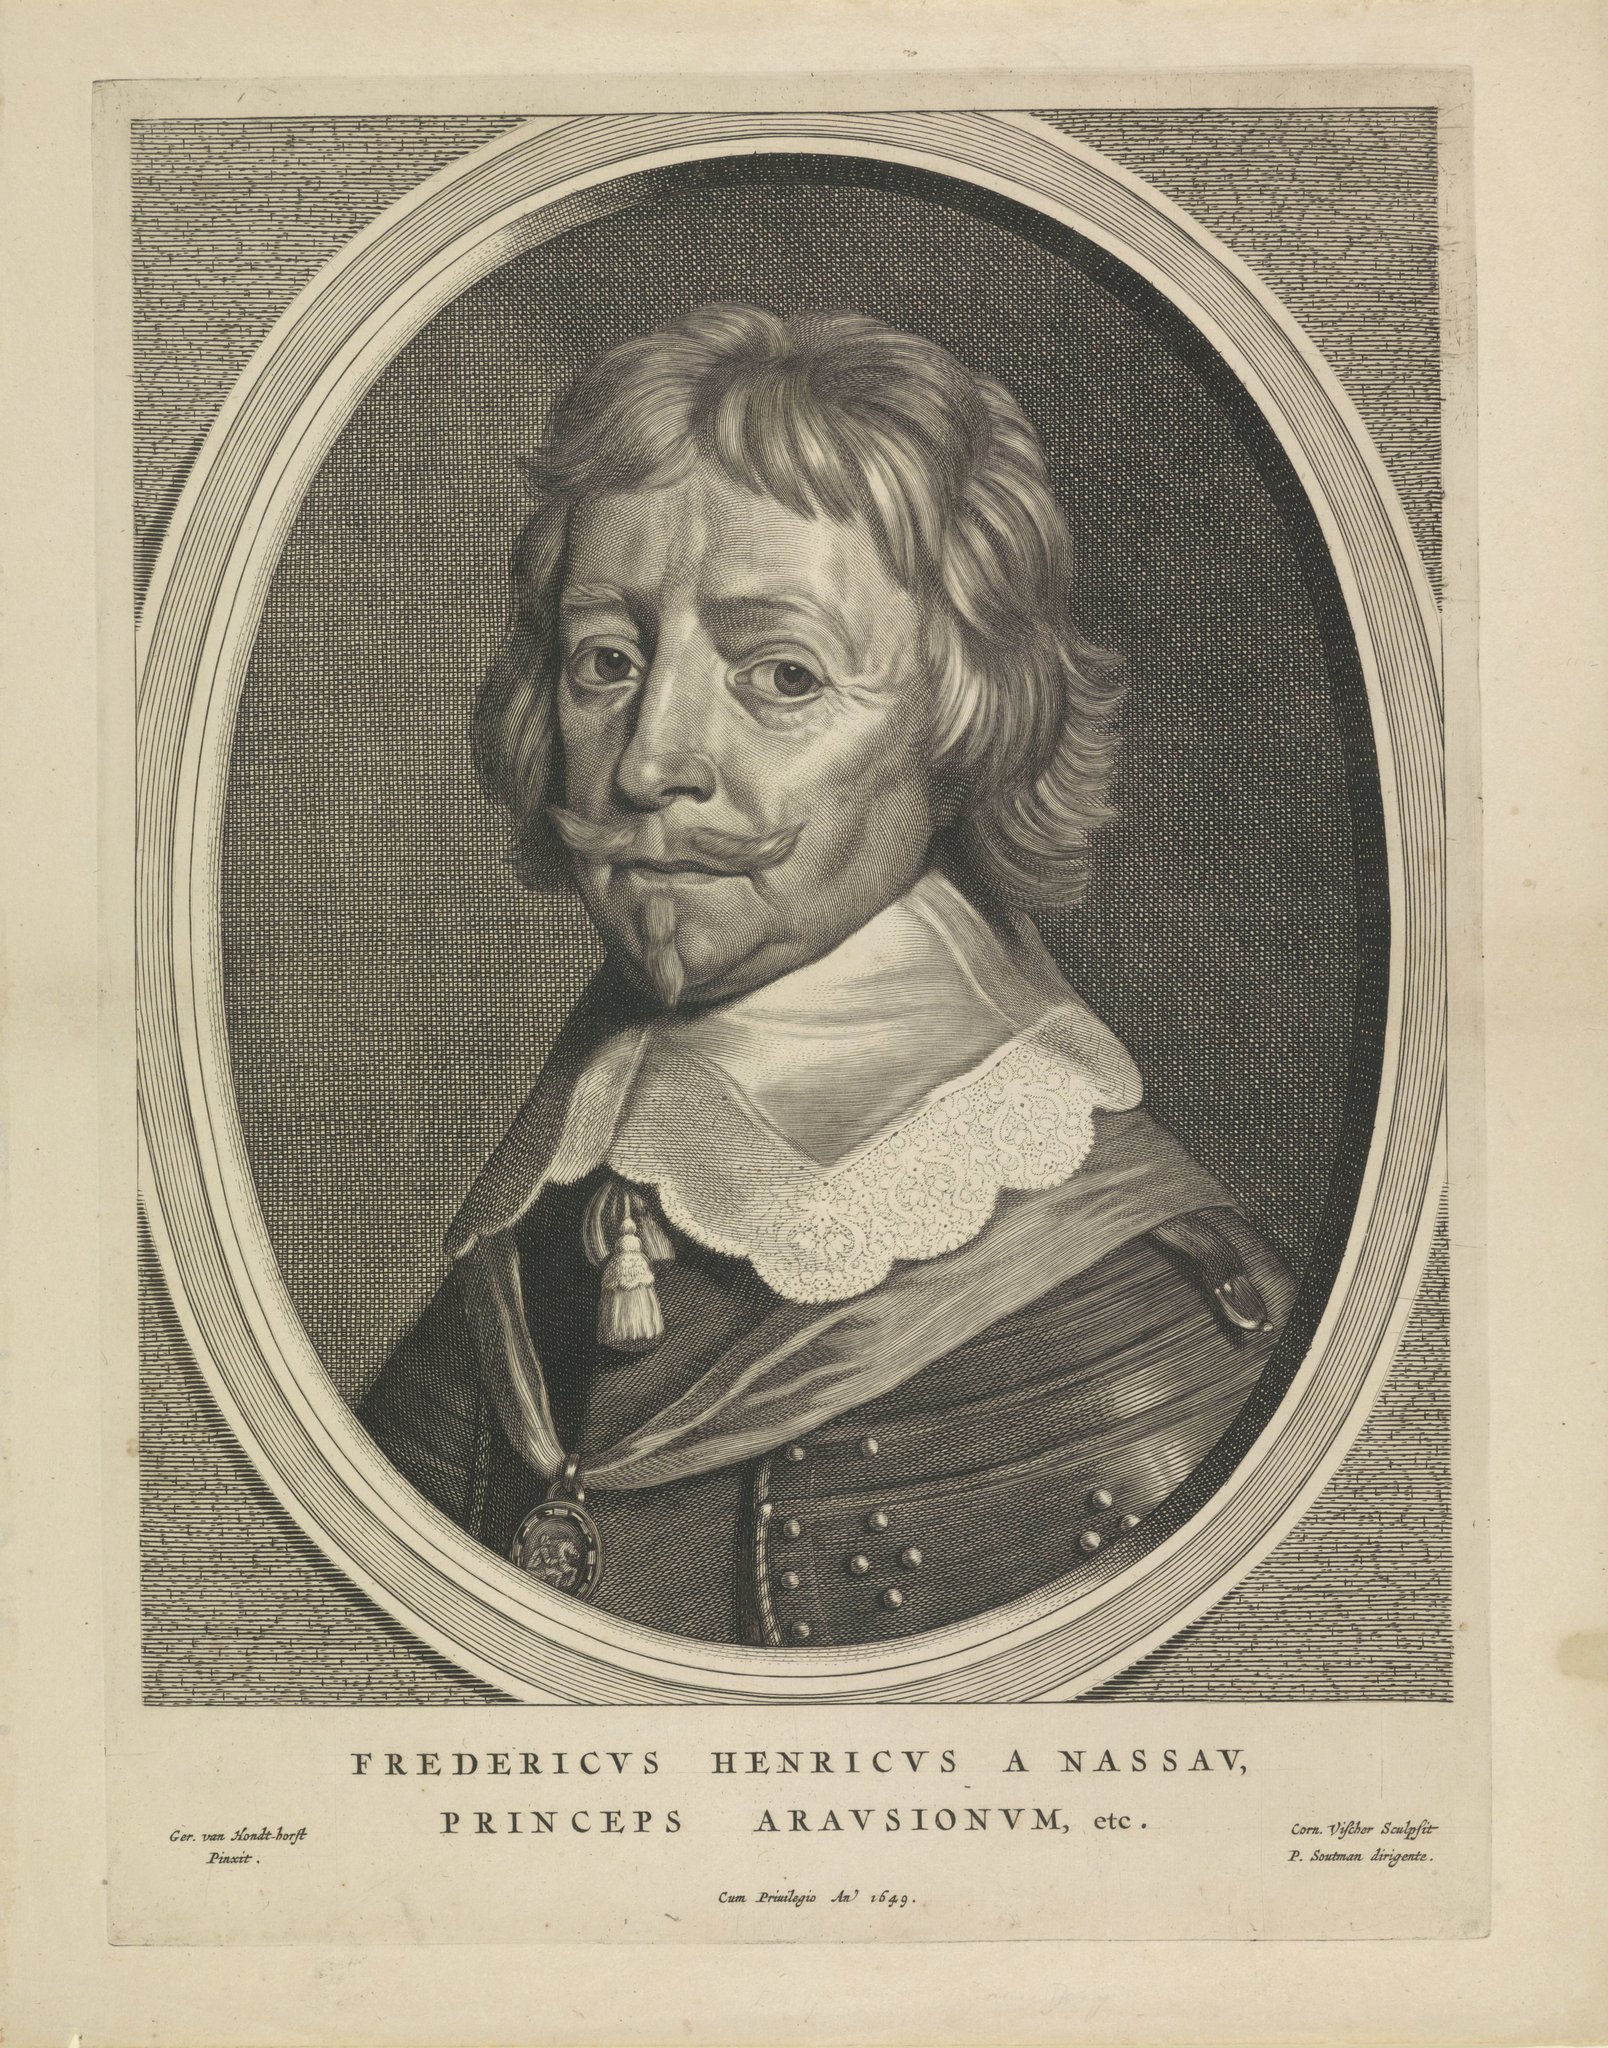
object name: print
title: Portret van Frederik Hendrik, prins van Oranje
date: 1649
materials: paper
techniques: engraving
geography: haarlem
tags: delft, the hague, frederick henry (prince of orange), knighthood order (garter) - insignia of a knighthood order, e.g.: badge, chain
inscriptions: date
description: De hier vermelde titel verwijst naar de hoogst verkregen titel van de geportretteerde, niet per se naar de titel die de geportretteerde op deze voorstelling draagt.